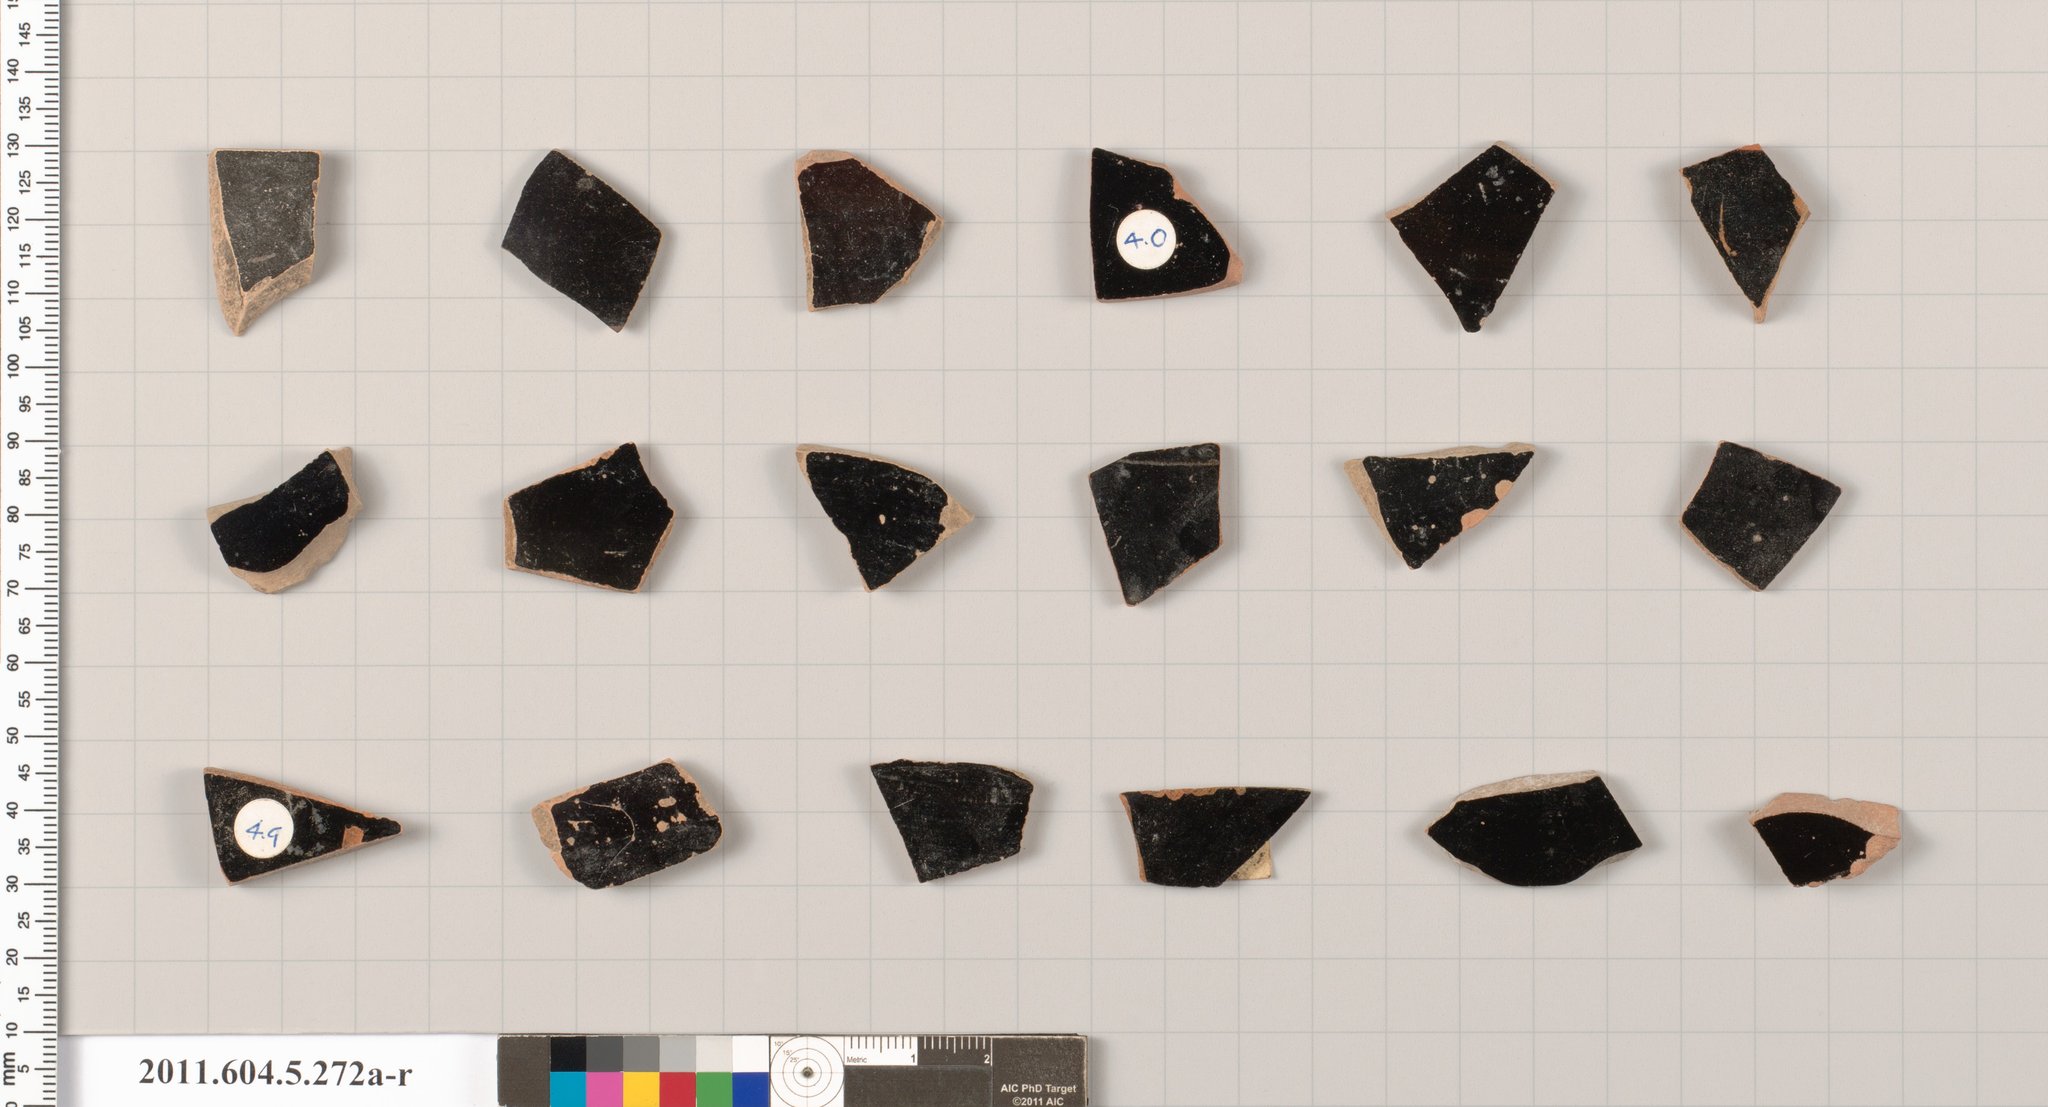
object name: kylix fragment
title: Terracotta fragments of kylikes (drinking cups)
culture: greek, attic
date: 600-401 BCE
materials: terracotta